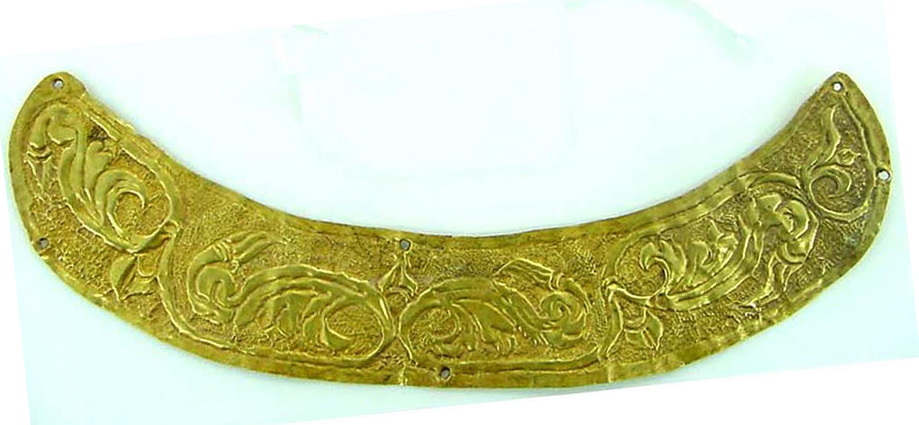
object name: plaque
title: Plaque with Vegetal Arabesque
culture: northwest chinese or eastern central asian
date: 634-900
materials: gold